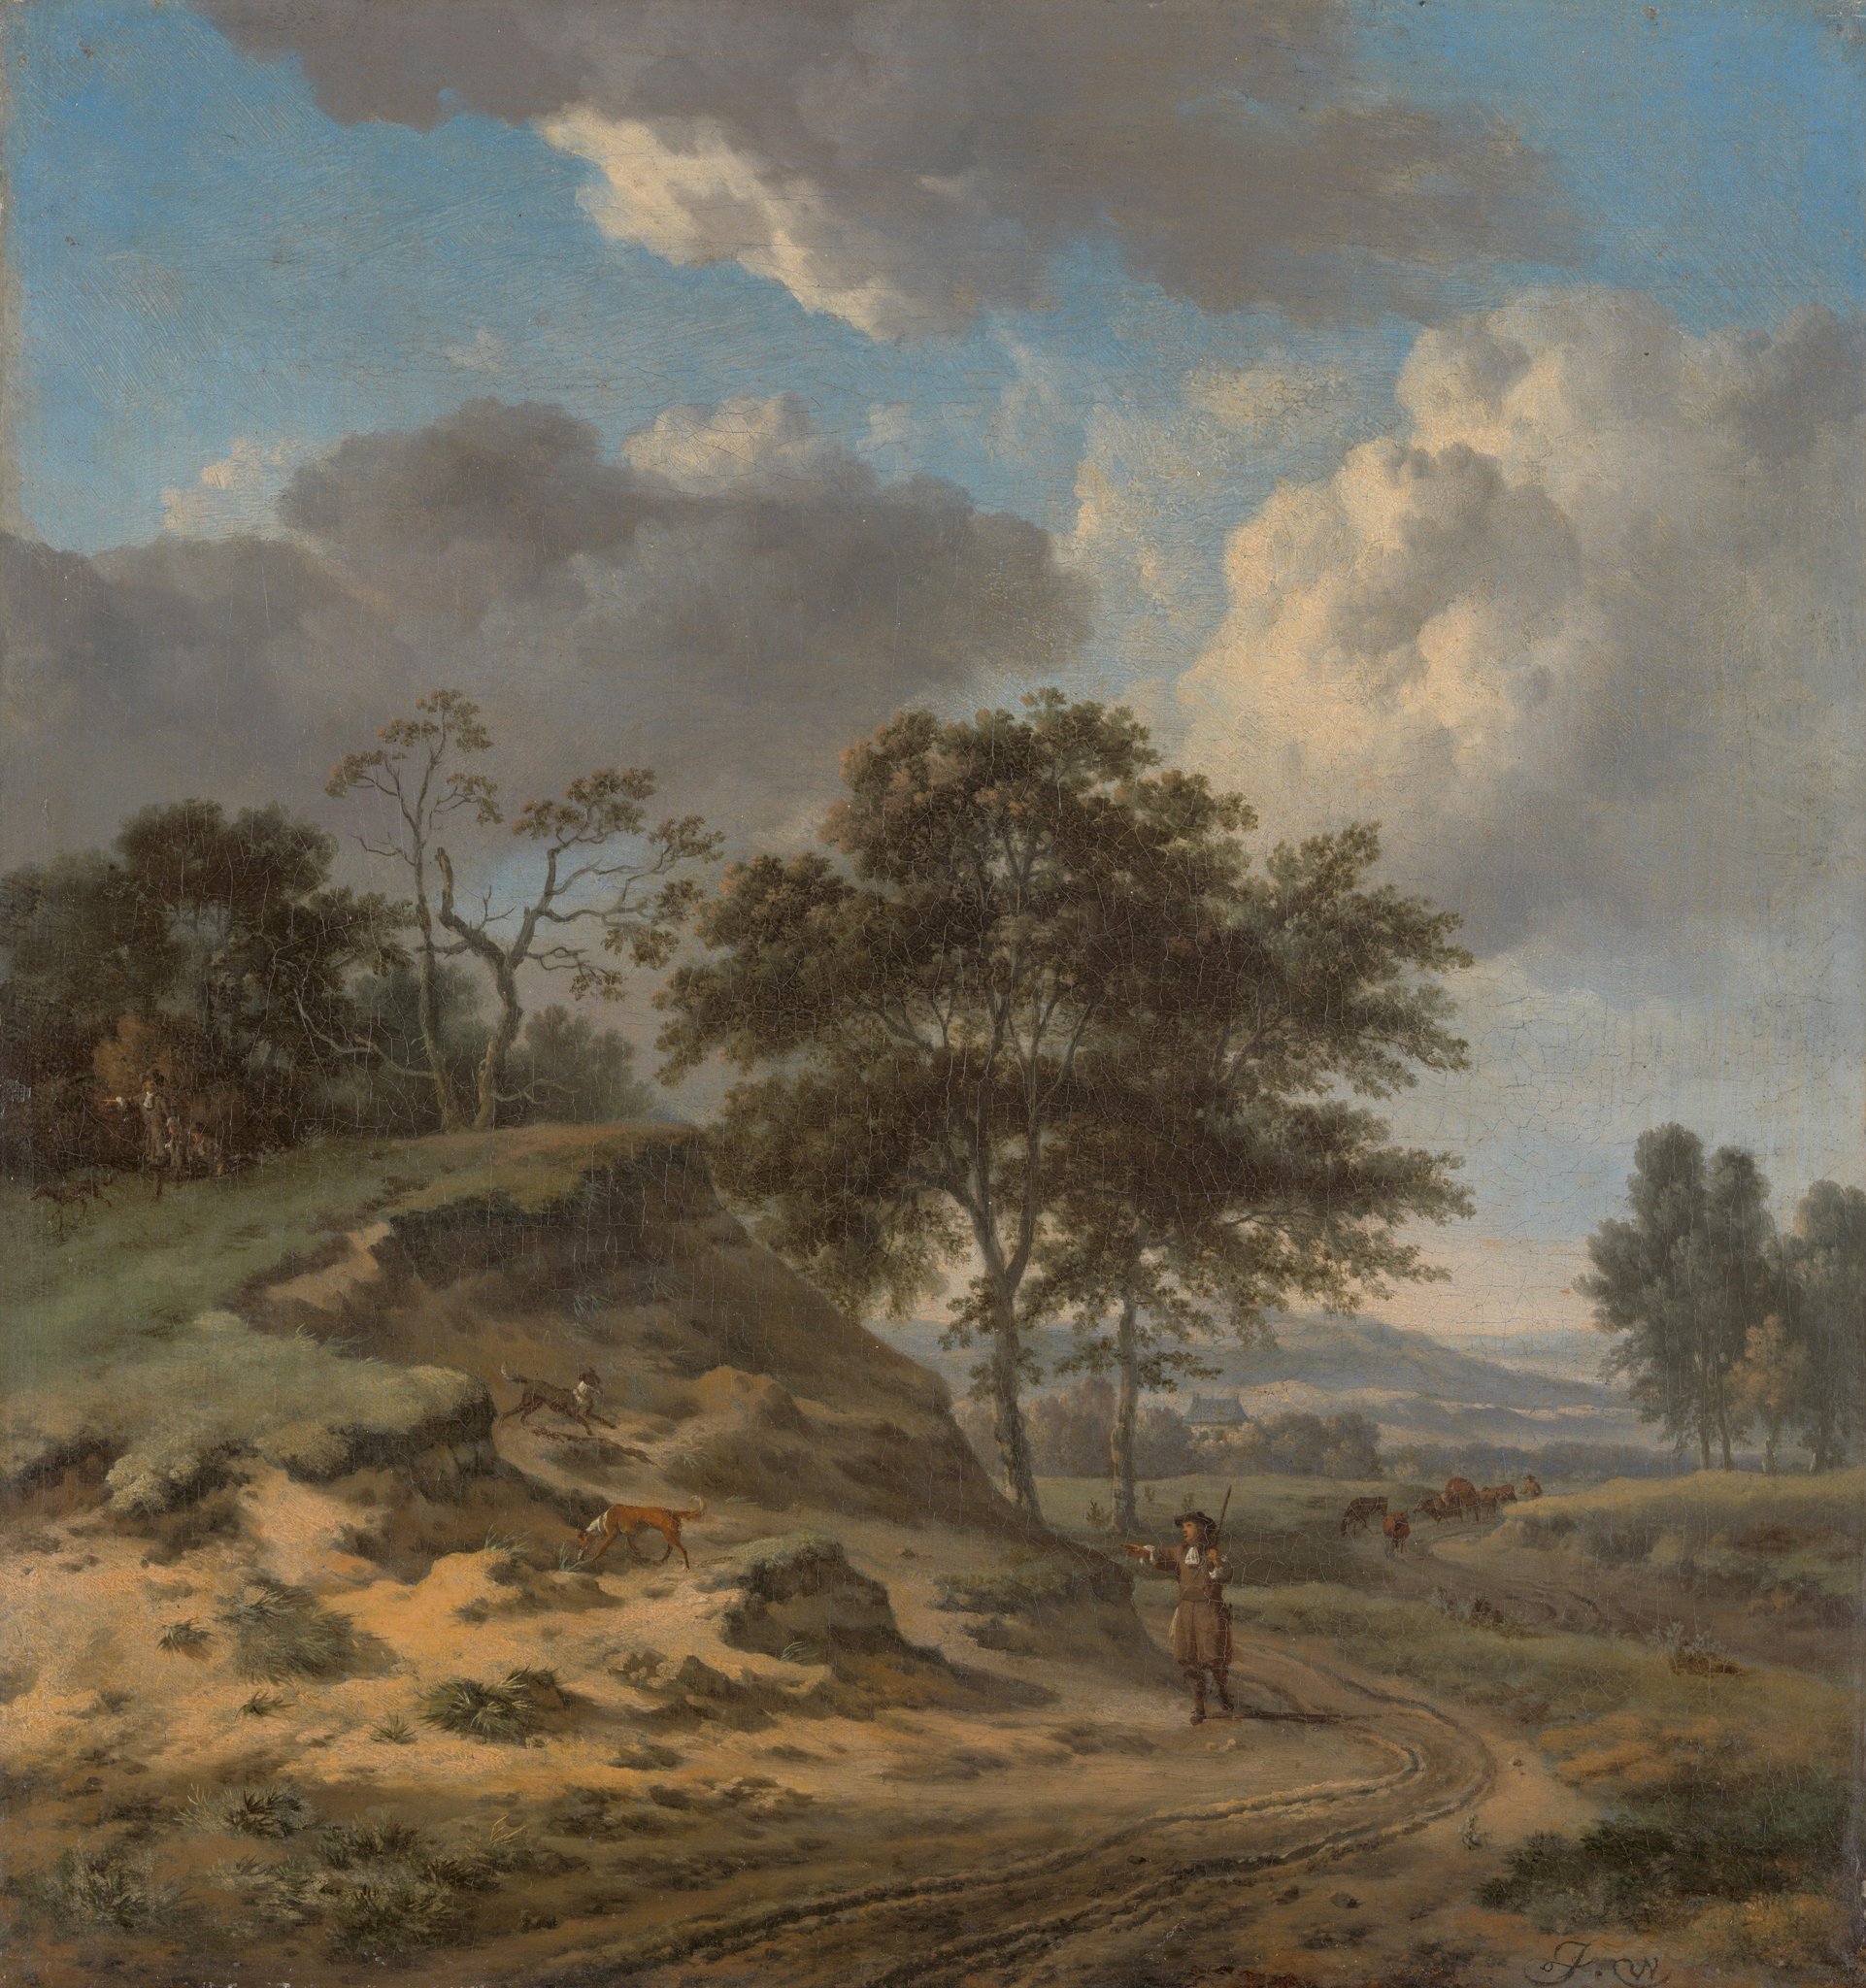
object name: painting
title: Landscape with two Hunters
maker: jan wijnants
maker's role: draughtsman, painter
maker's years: 1632-1684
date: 1655-1684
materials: canvas, oil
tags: low hill country, hunters hunting (n.b.: in 1988-1990 this notation denoted the concept of 43c11421 'hunters resting during the hunt')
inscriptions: signature: ‘J.W.’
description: Landschap met twee jagers. Jagers met honden bij een landweg dat langs een duin loopt. In de verte een boerderij of buitenplaats.